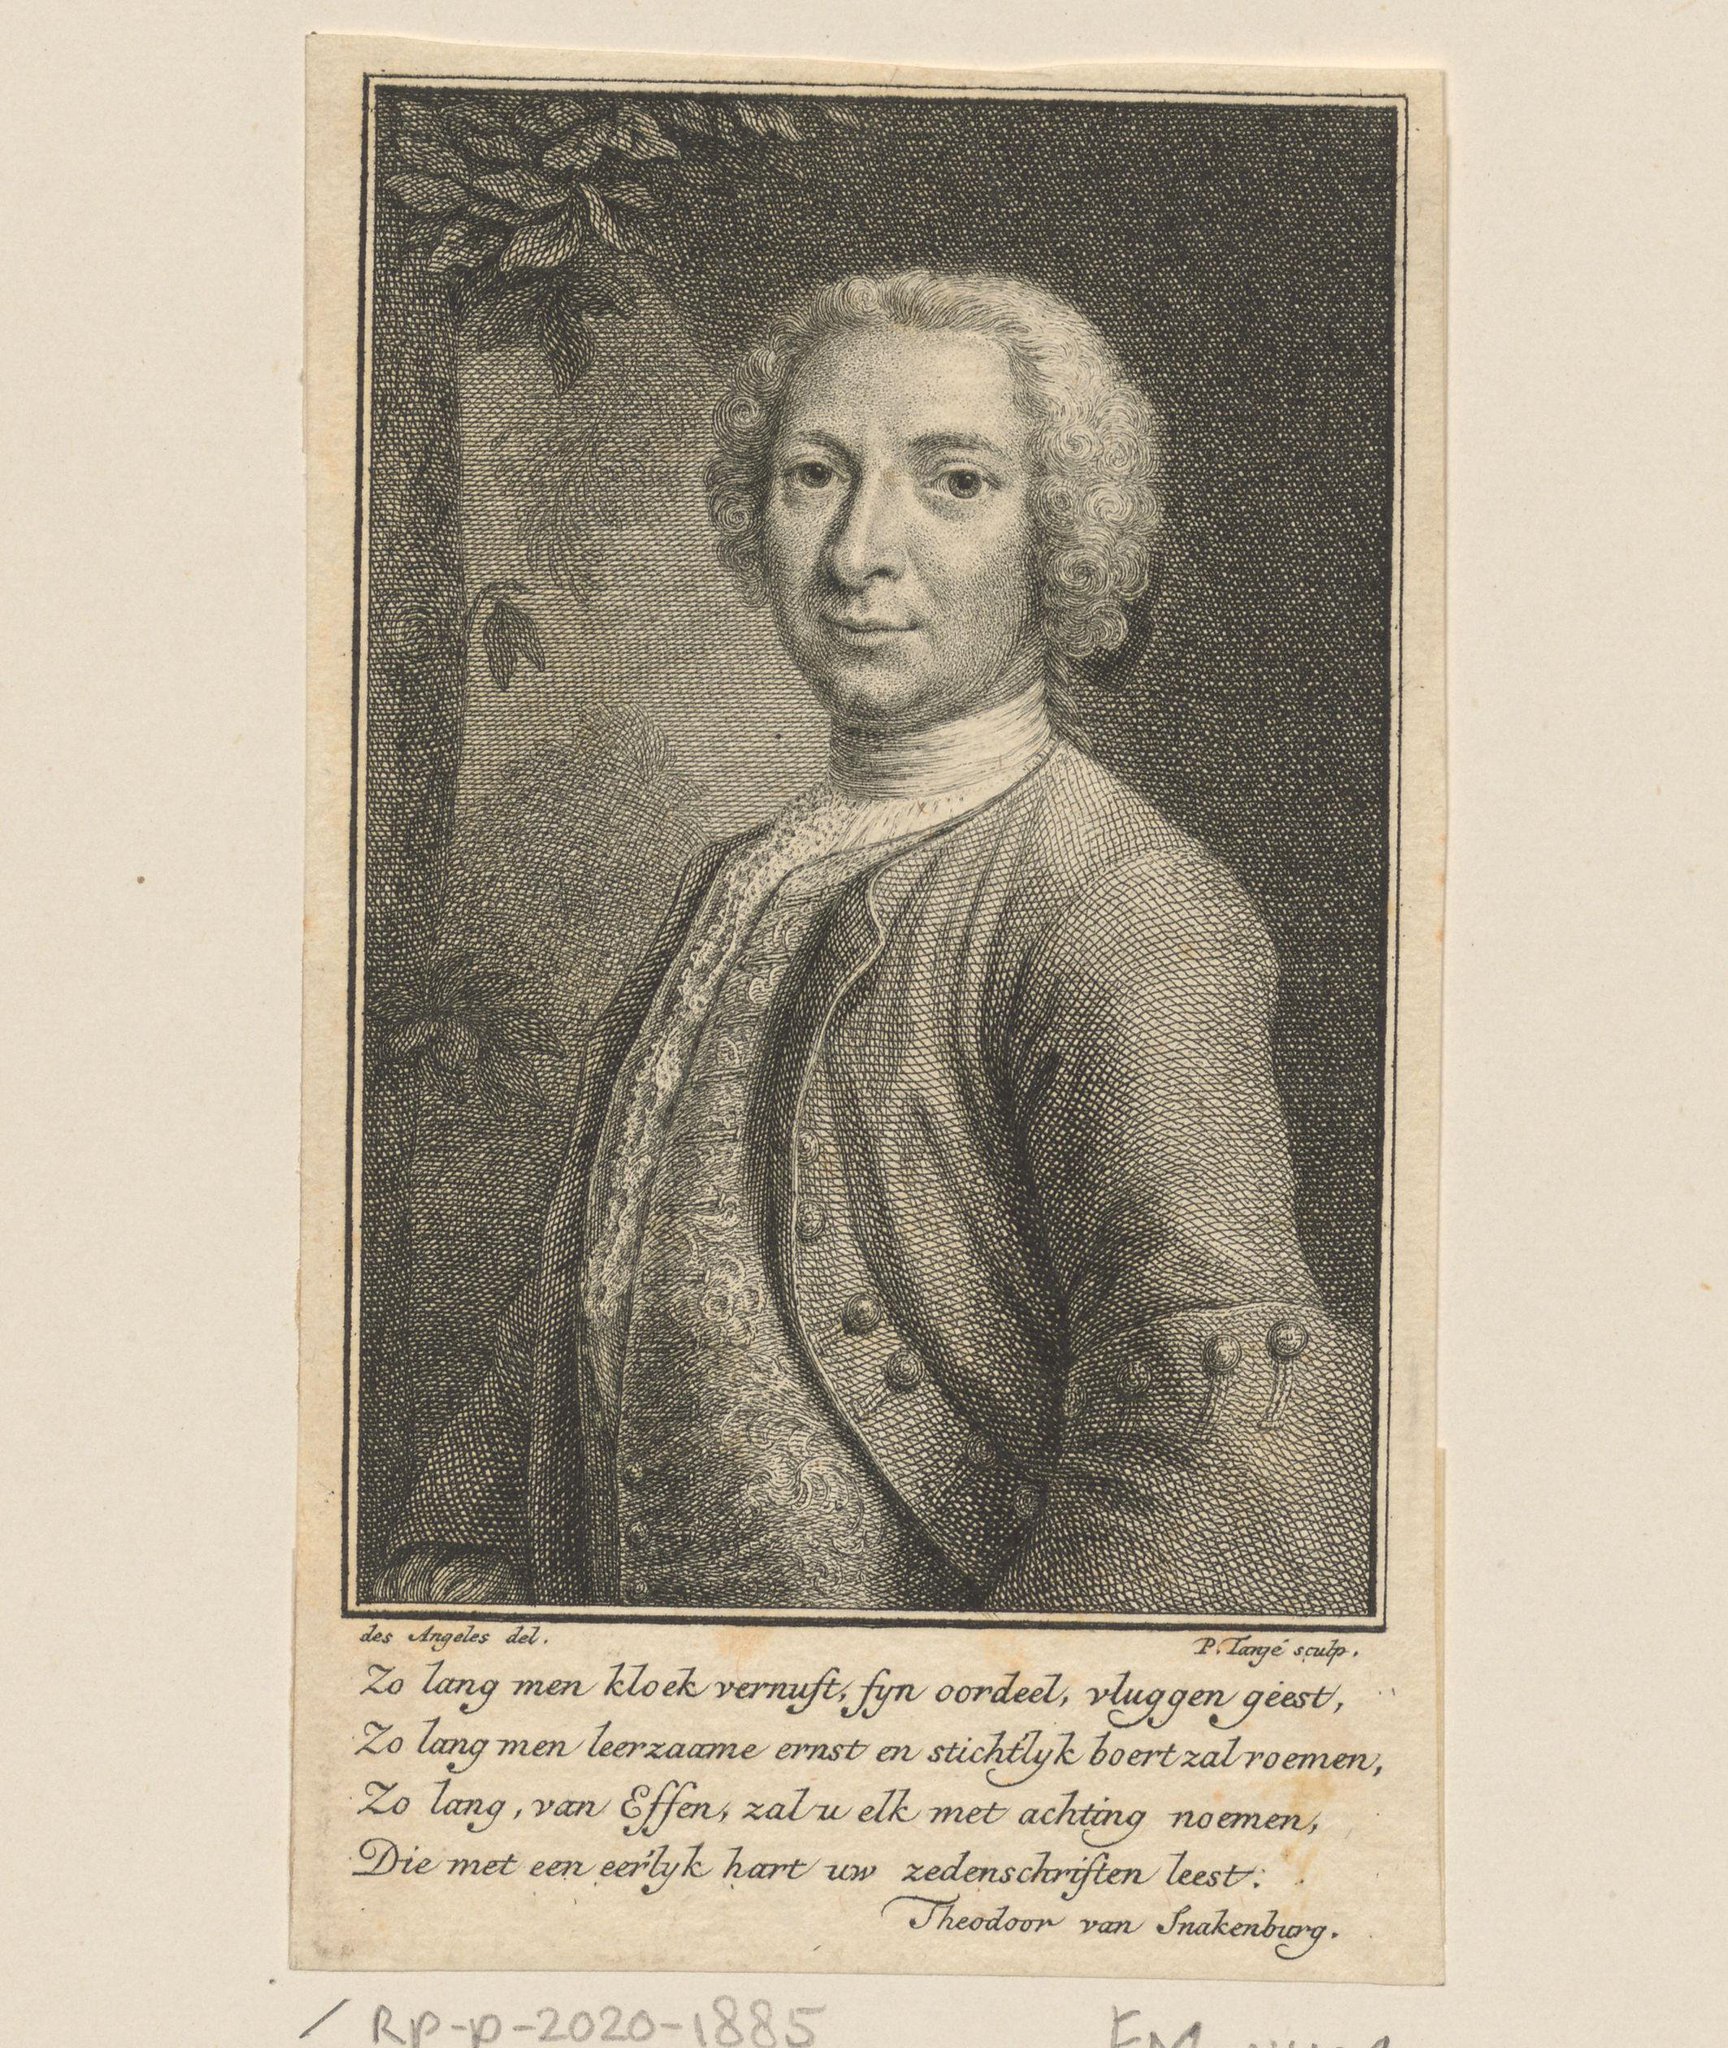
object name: print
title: Portret van Justus van Effen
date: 1716-1761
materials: paper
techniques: etching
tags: utrecht, den bosch, historical persons, portrait of a writer